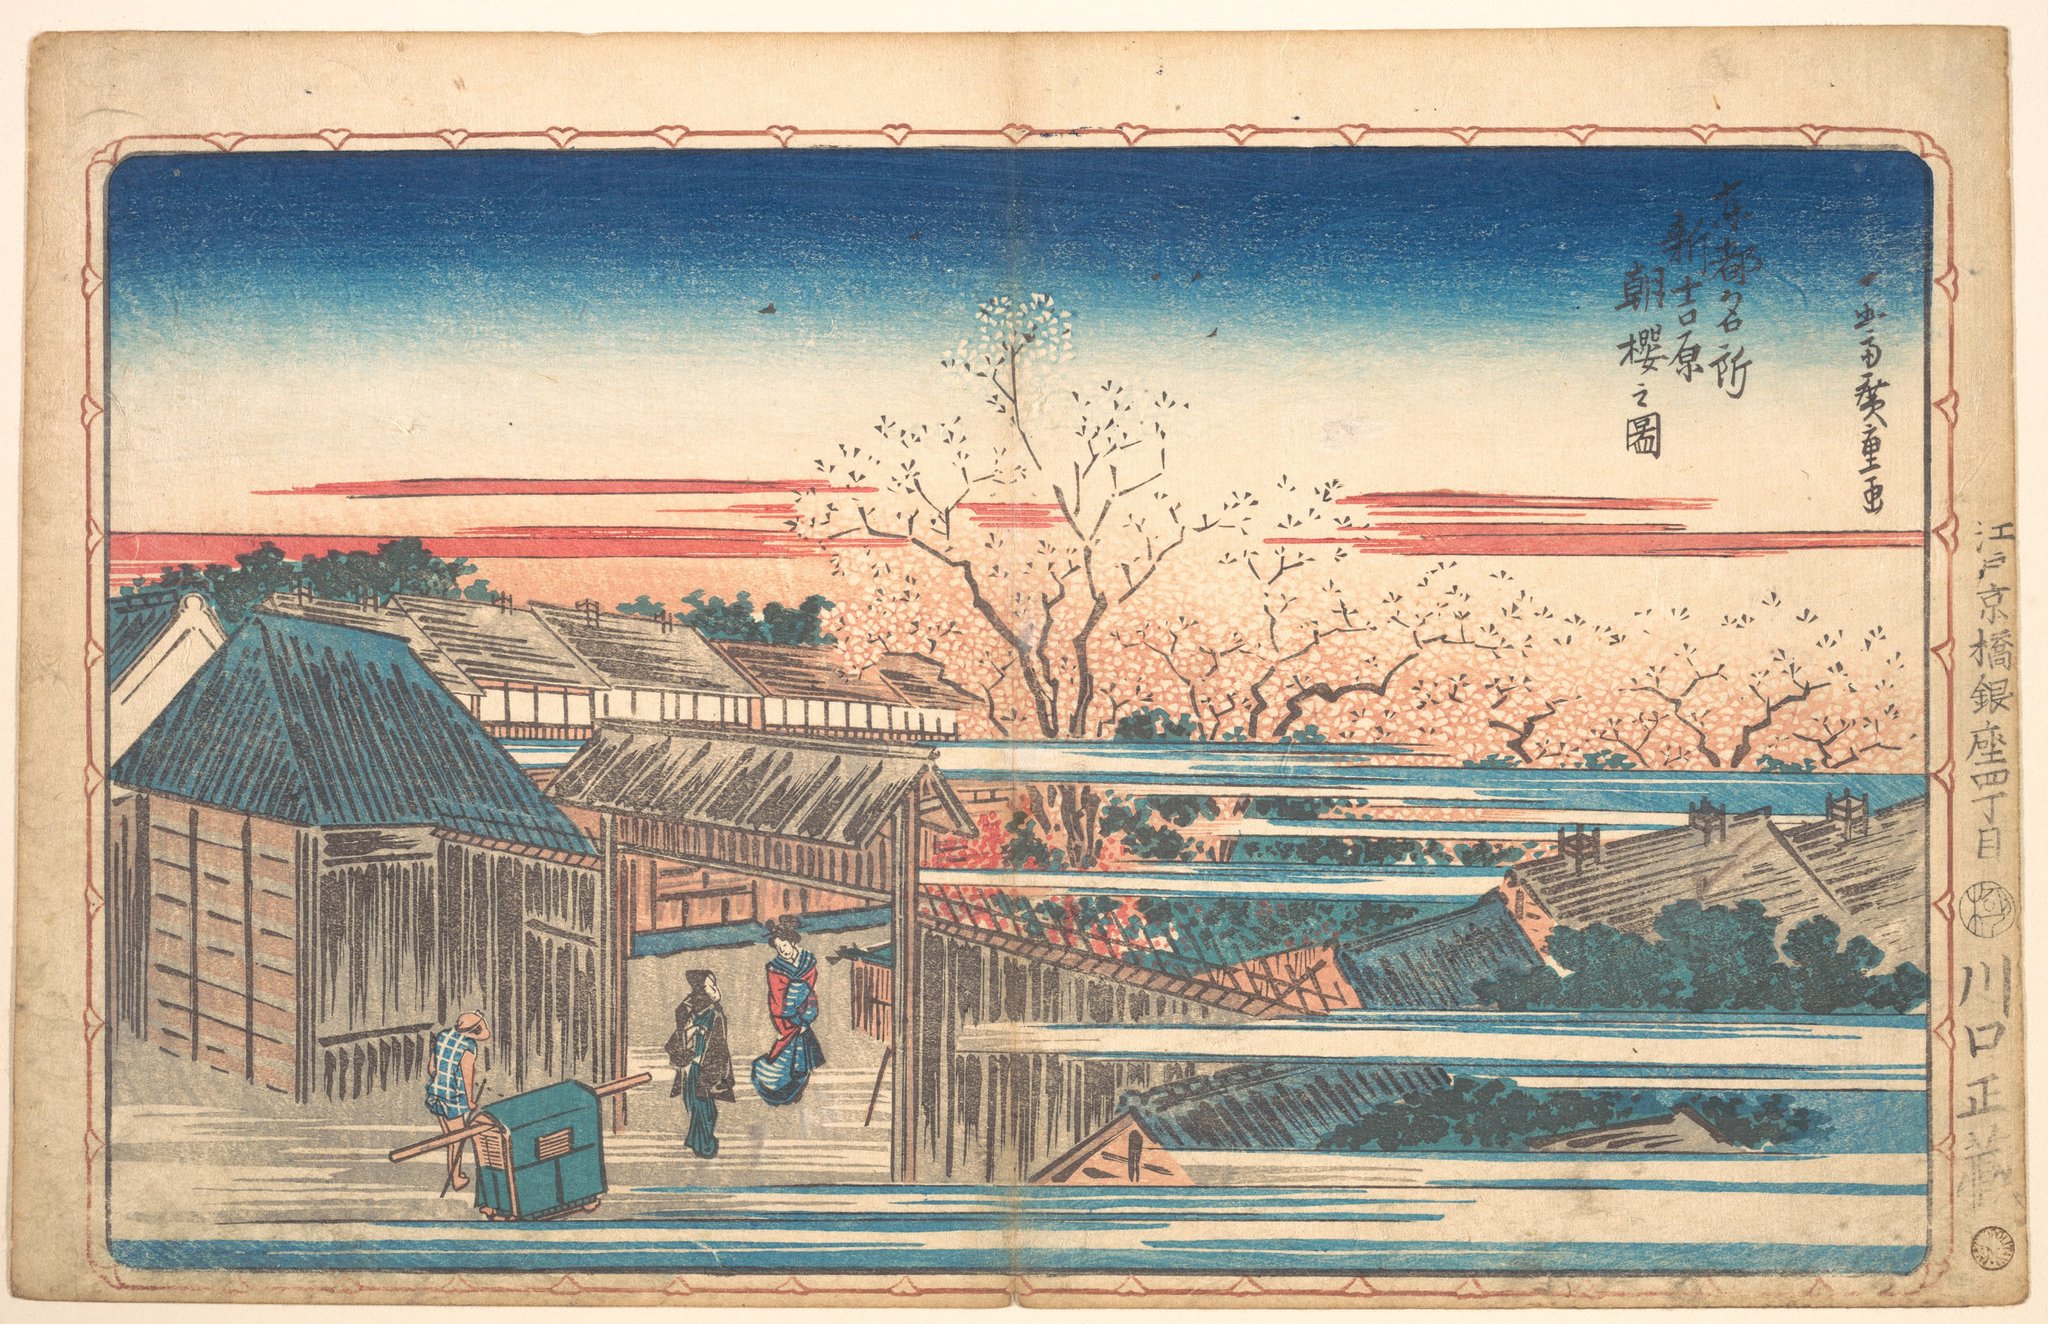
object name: print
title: Morning Cherries at Yoshiwara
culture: japanese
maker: utagawa hiroshige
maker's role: artist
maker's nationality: japanese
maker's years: 1797-1858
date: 1797-1858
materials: ink, paper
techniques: woodblock print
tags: human figures,houses,trees,morning